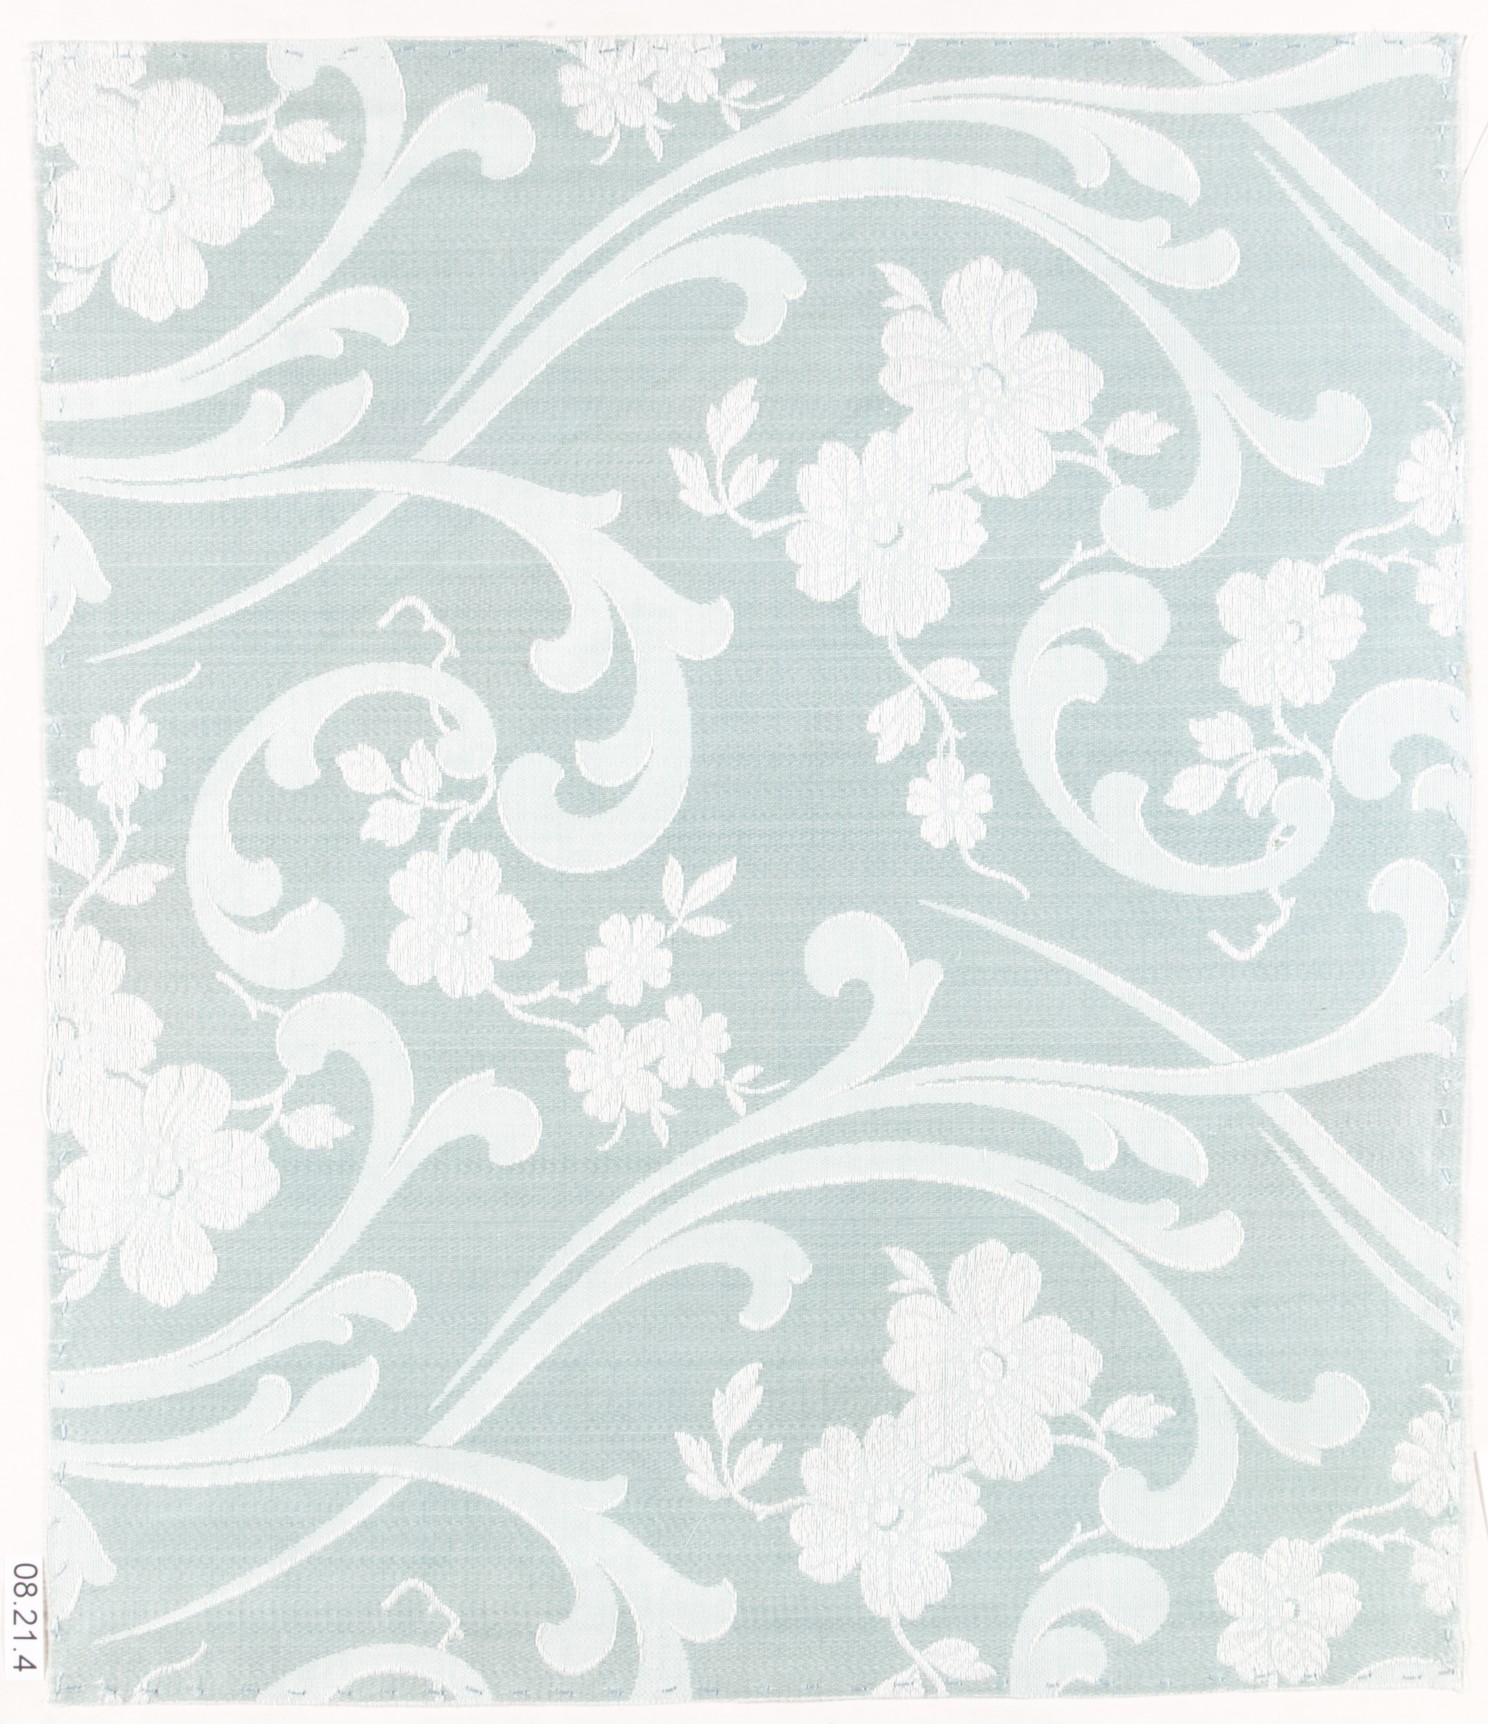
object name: textile sample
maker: Anonymous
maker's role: designer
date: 1900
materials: silk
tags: flowers